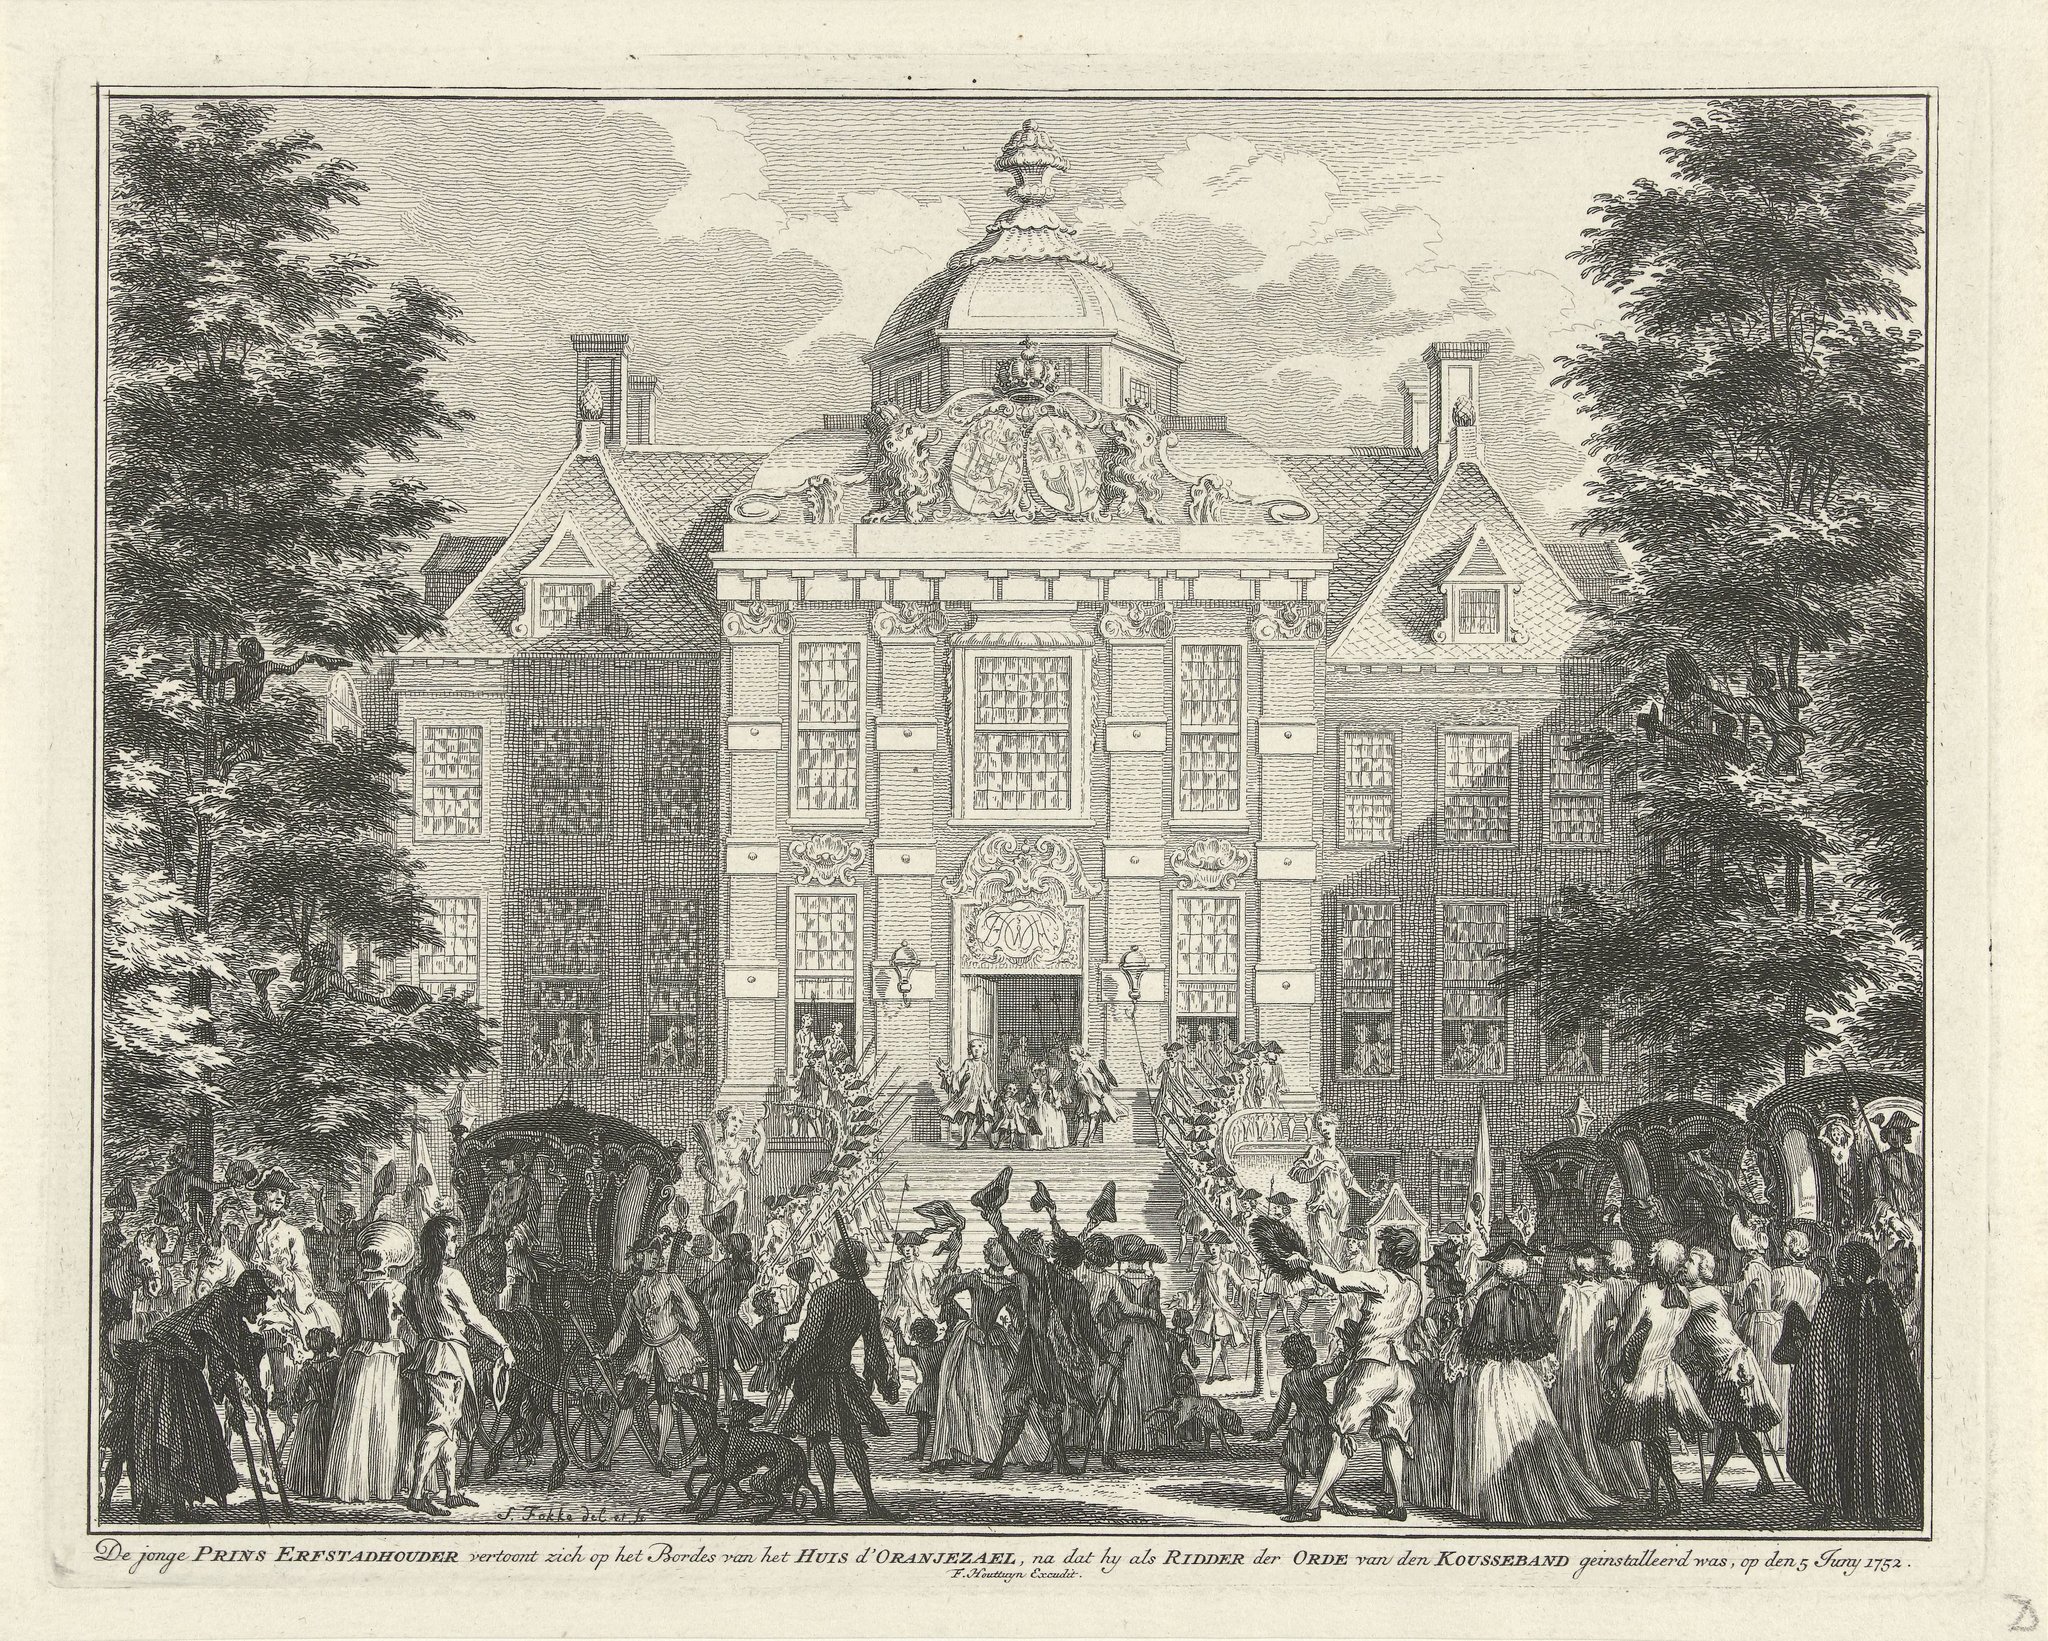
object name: print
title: Willem V vertoont zich als Ridder van de Kousenband, 1752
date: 1752-1754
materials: paper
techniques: etching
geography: amsterdam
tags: the hague, william v (prince of orange)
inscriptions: collector's mark: Lugt 2228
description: De jonge Willem V vertoont zich als Ridder van de Kousenband op het bordes van het Koninklijk Paleis Huis ten Bosch. Op de voorgrond juicht een menigte mensen hem toe.